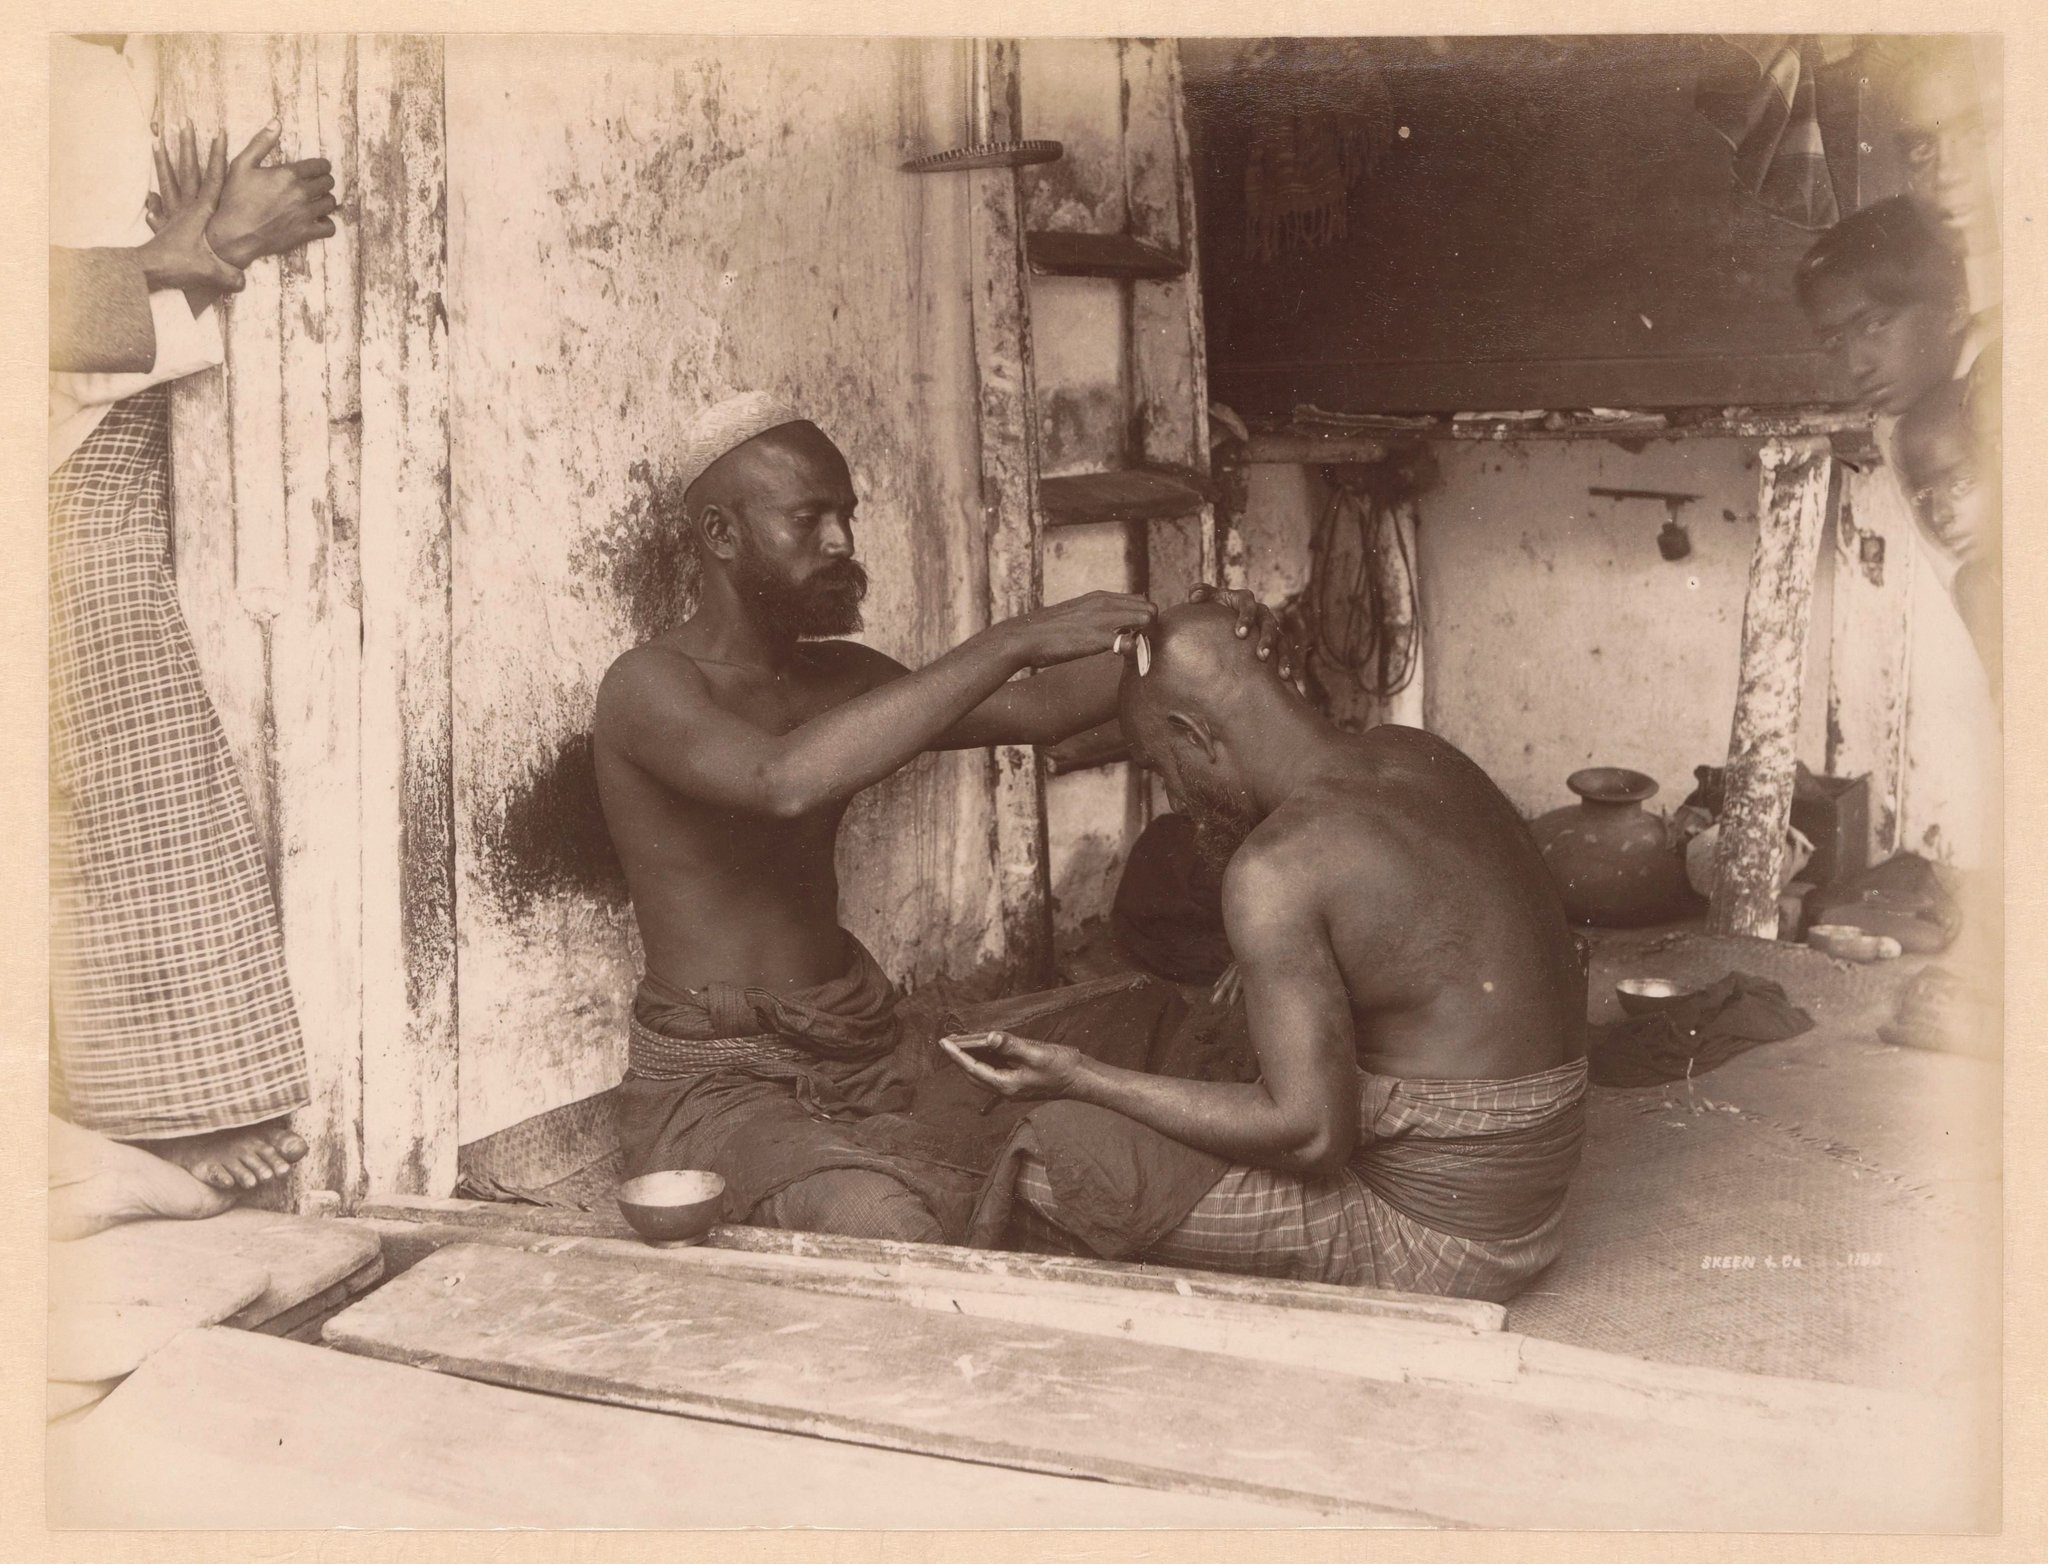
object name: photograph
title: Seated man shaving another man's head, Sri Lanka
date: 1862-1903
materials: paper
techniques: albumen print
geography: sri lanka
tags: shaving, being shaved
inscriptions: signature: ‘Skeen & Co.’, inscription: ‘Moor barbers’, number: ‘148’, number: ‘1185’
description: Twee mannen zitten op de grond, de linker man is de kapper, van de rechter man wordt zijn hoofd kaal geschoren. In de rechter bovenhoek zijn drie jongens zichtbaar die nog net binnen het zicht van de lens vallen. Aan de linkerkant wordt iemand tegen gehouden die door het beeld wil lopen.